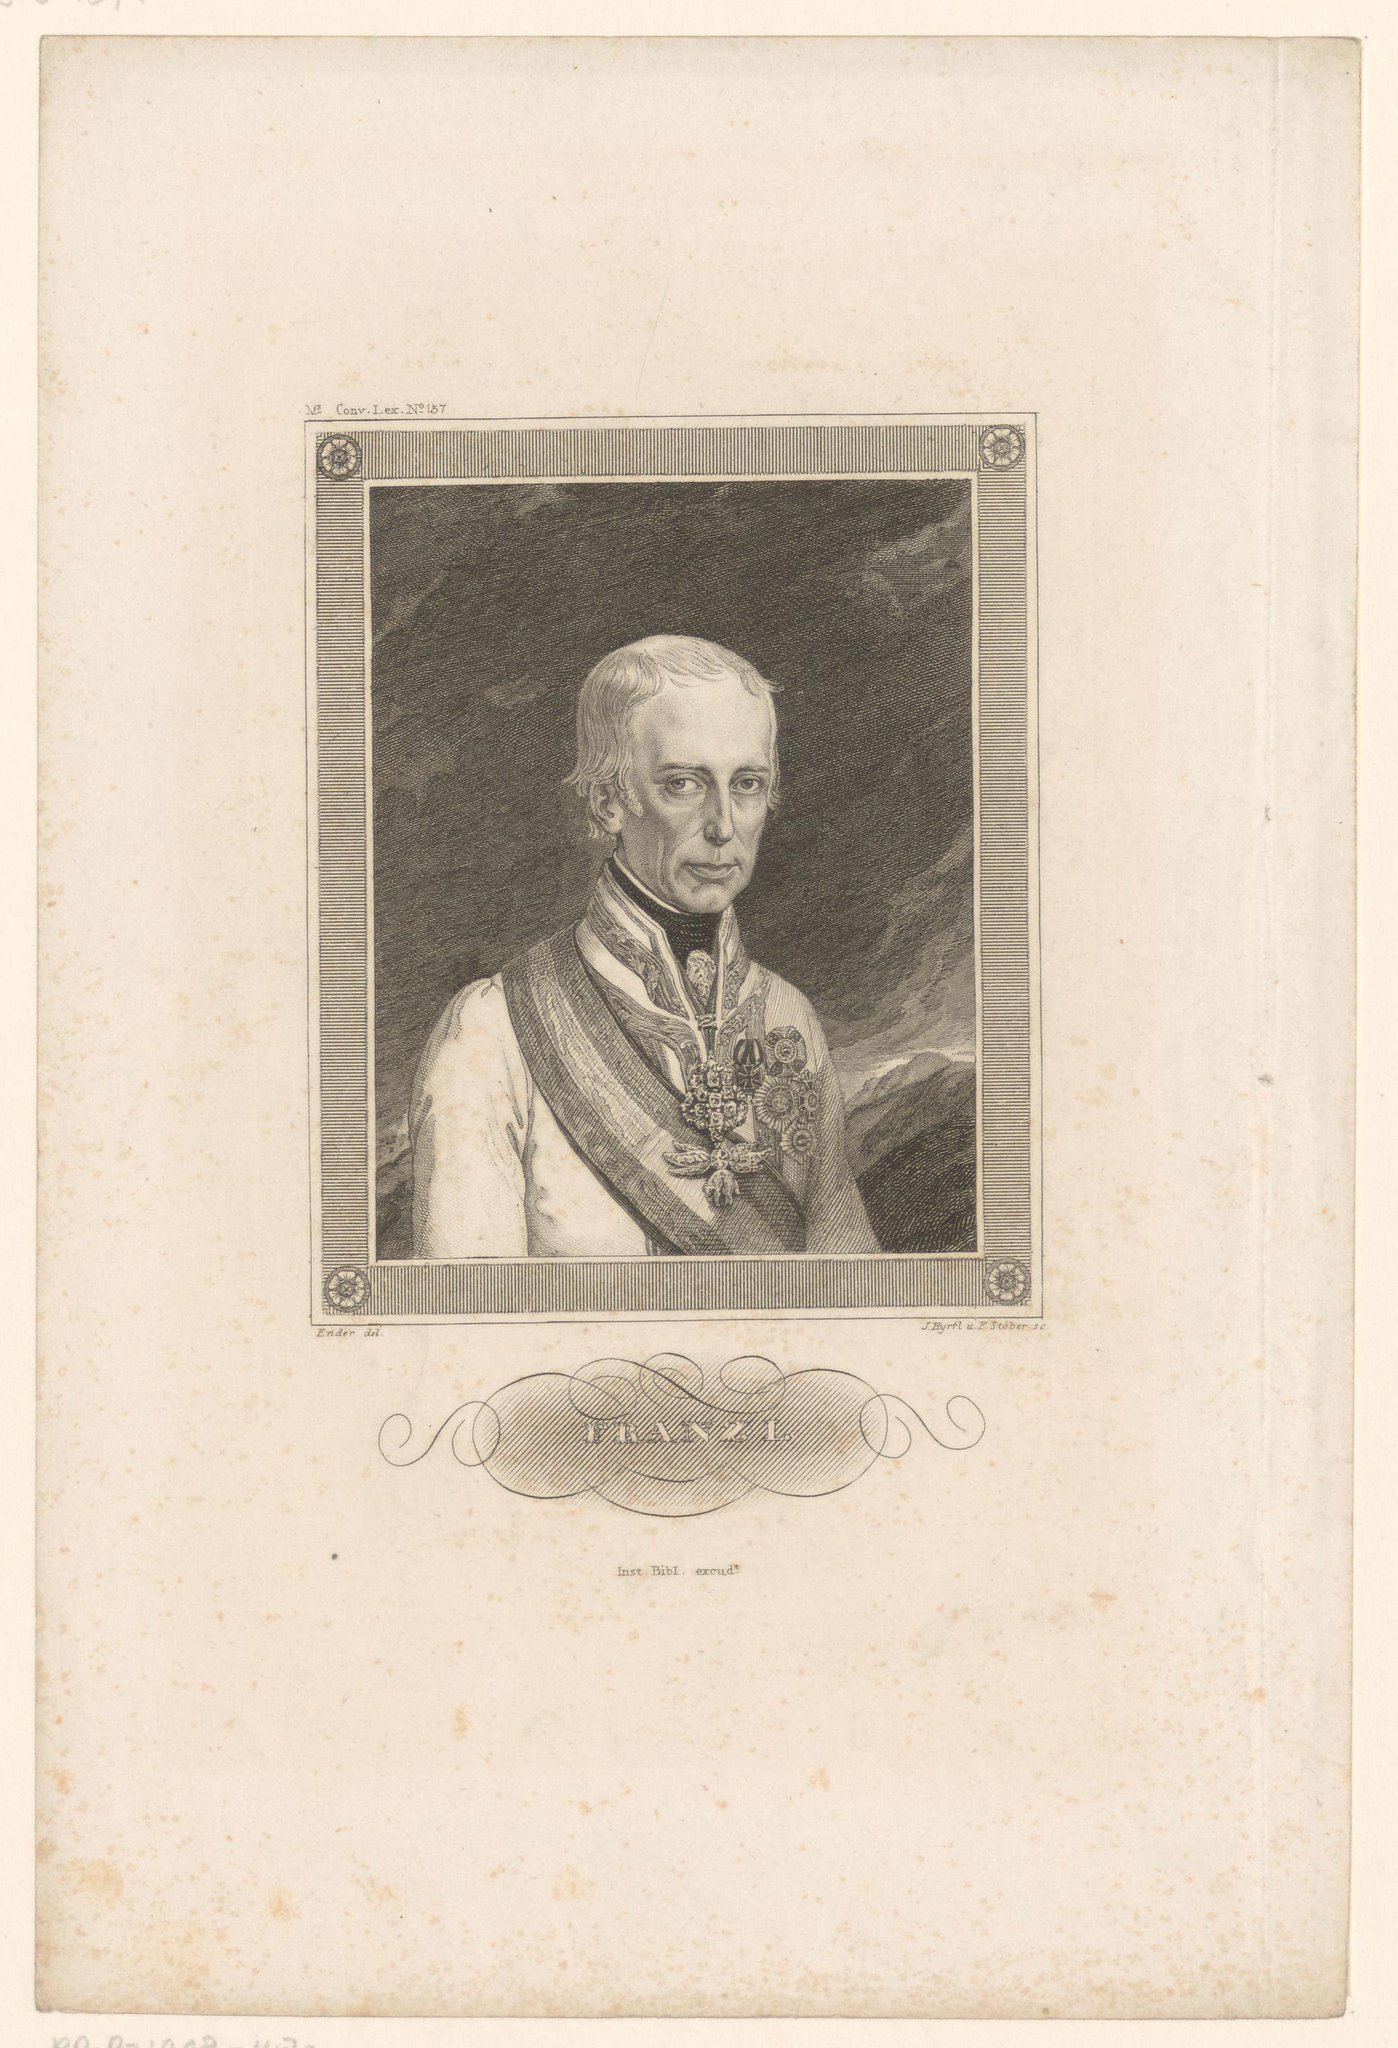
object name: print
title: Portret van Frans II Josef Karel, Rooms-Duits keizer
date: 1840-1855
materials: paper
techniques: engraving, etching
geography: hildburghausen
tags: frans ii (rooms-duits keizer), knighthood order: teutonic order - insignia of a knighthood order, e.g.: badge, chain (with name of order), historical persons, knighthood order of the golden fleece - insignia of a knighthood order, e.g.: badge, chain (with name of order)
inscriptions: collector's mark: Lugt 2228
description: Prent uit: Meyer, Joseph. Das Grosse Conversations-Lexikon für die gebildeten Stände. Hildburghausen: Bibliographisches Institut, [1840-1855].